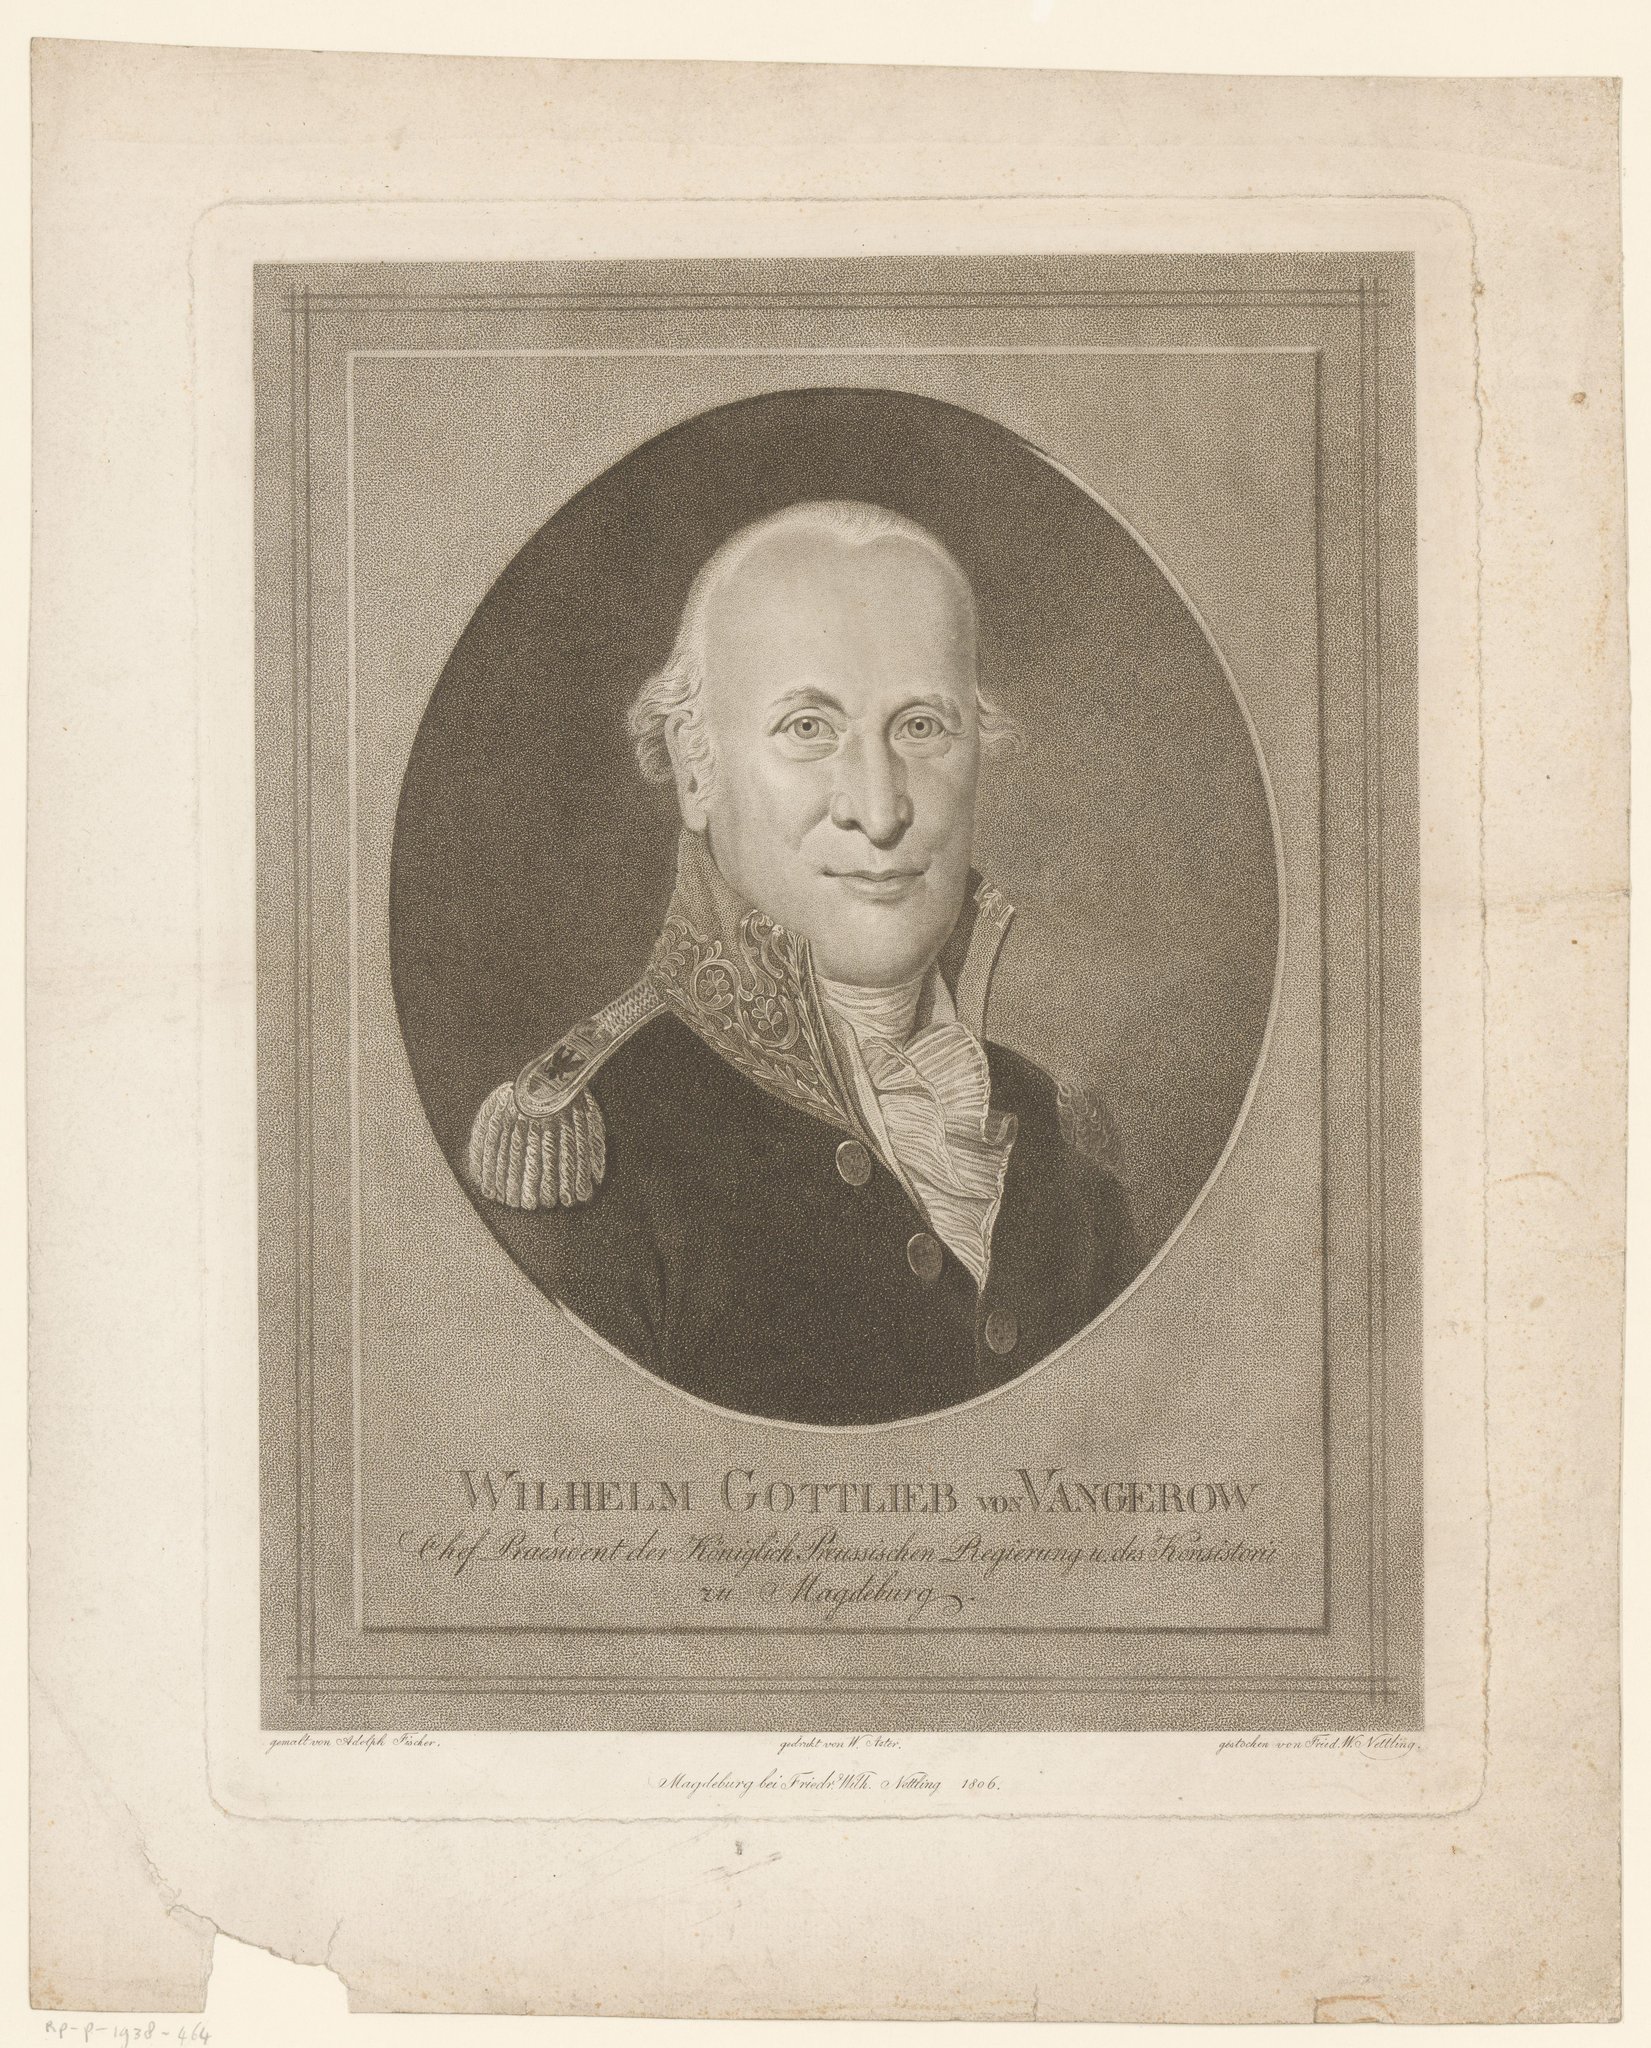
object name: print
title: Portret van Wilhelm Gottlieb Vangerow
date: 1806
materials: paper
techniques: engraving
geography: magdeburg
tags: historical persons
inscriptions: collector's mark: Lugt 2228